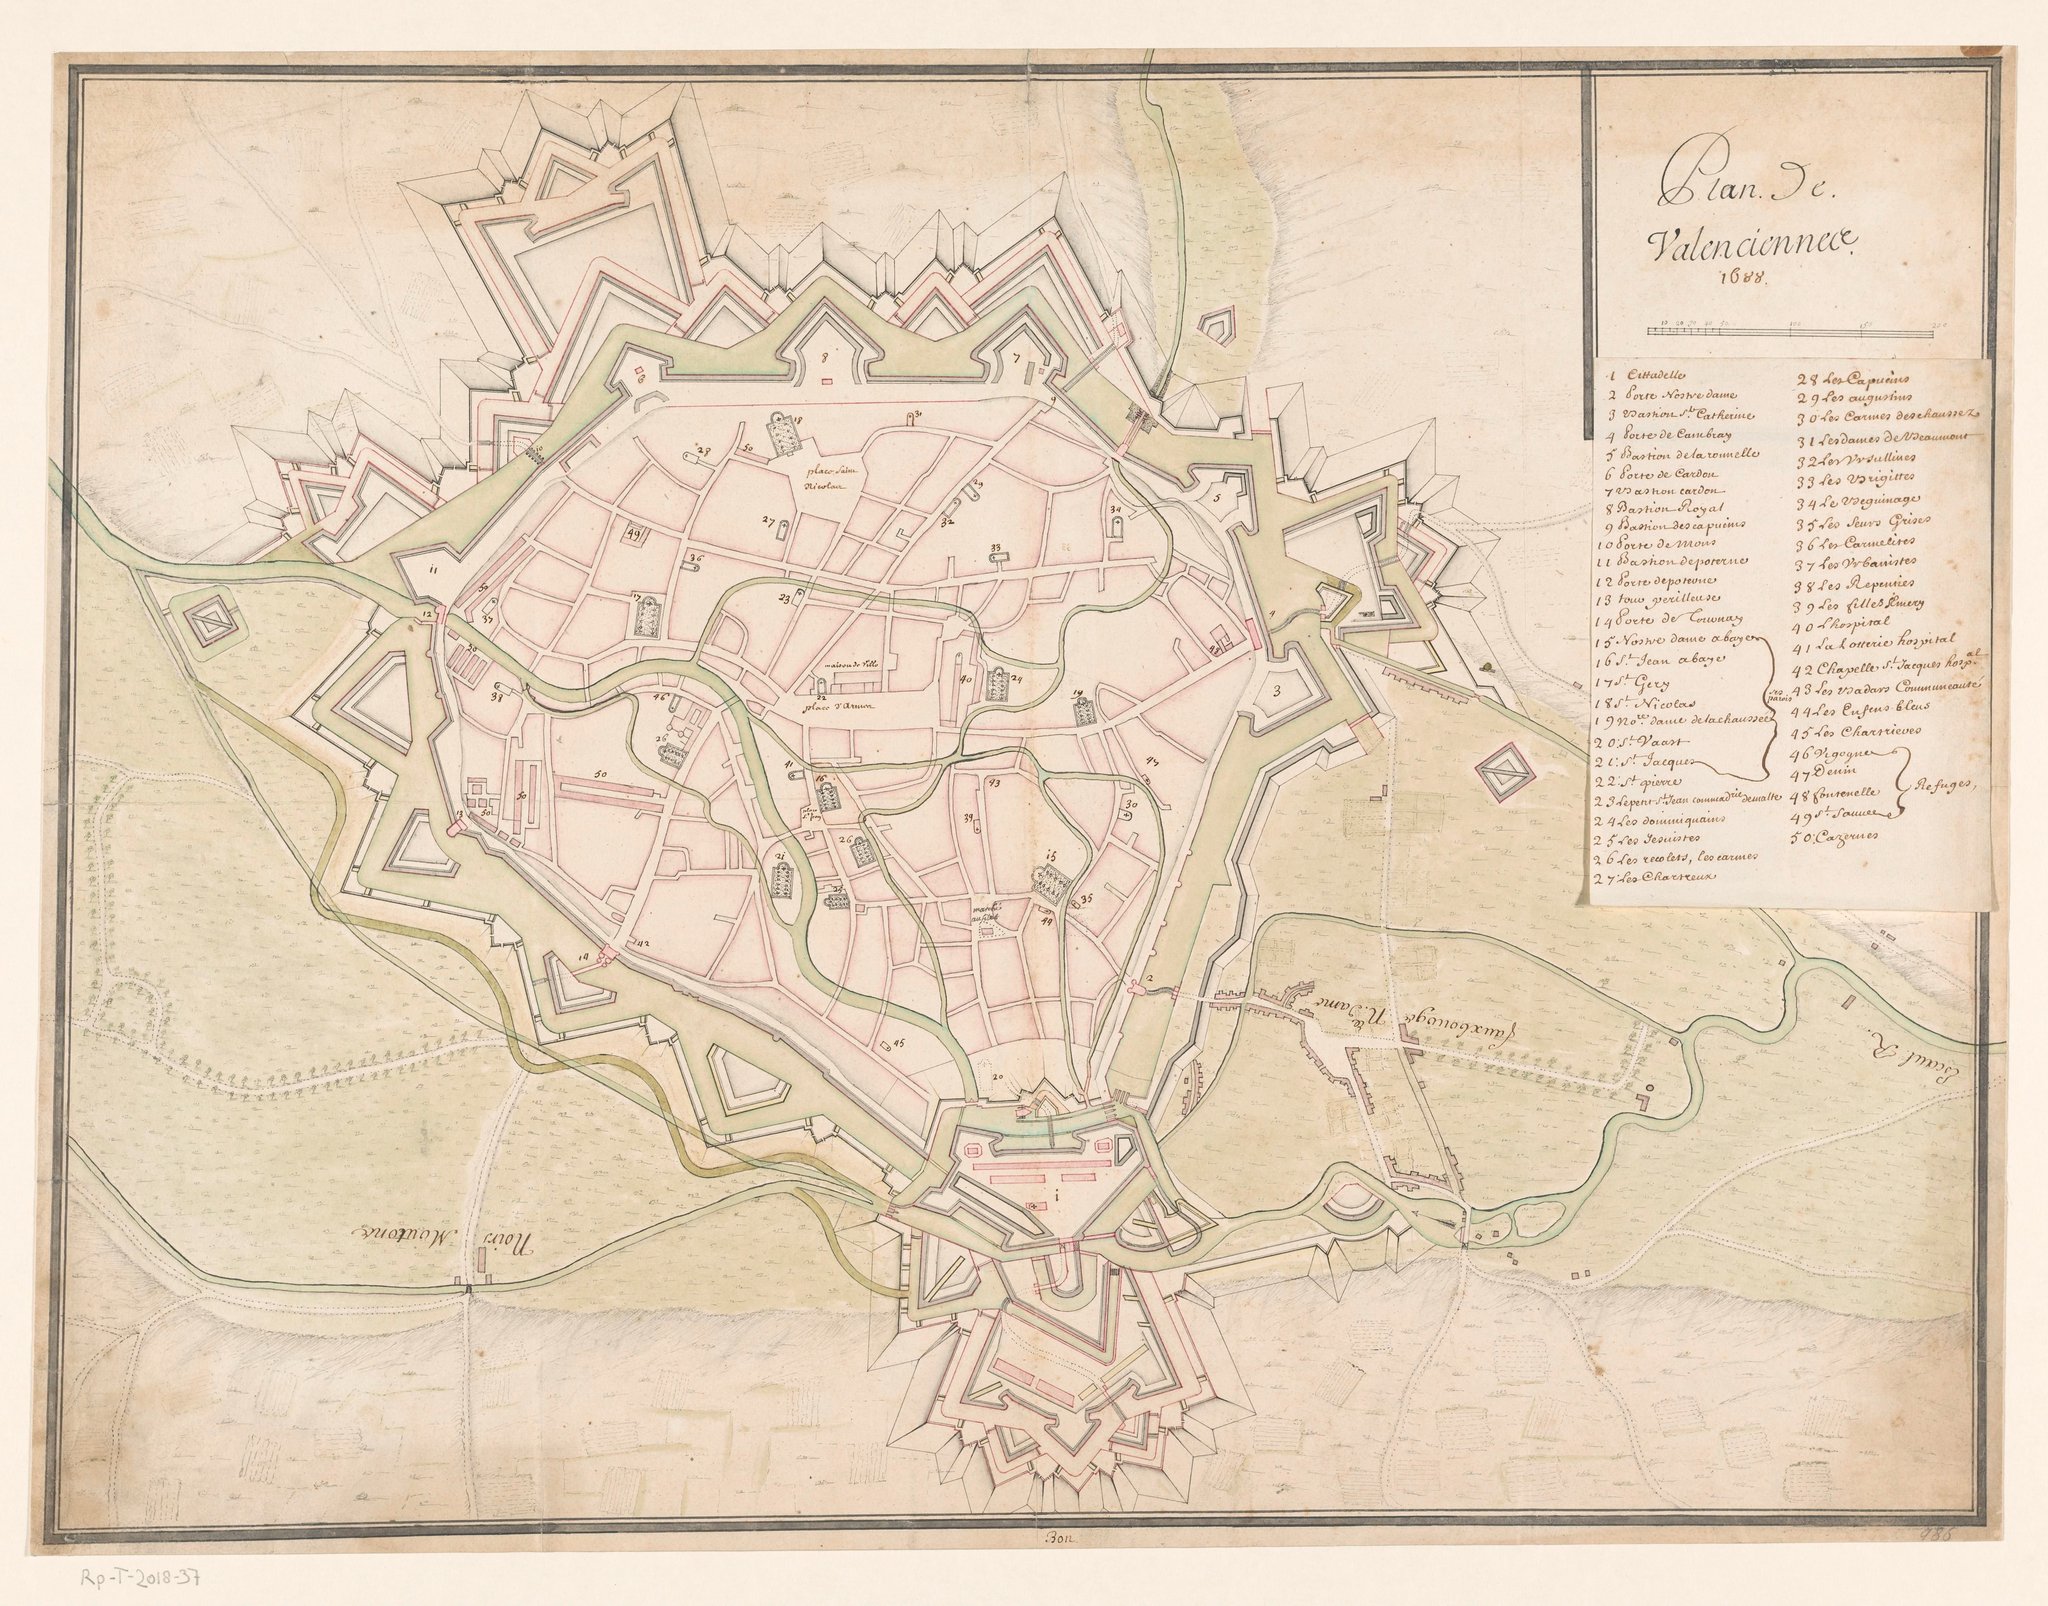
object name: bookplate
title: Rossica/ Russisches Antiquariat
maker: Anonymous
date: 1921-1932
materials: paper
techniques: printing block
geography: germany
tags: flowers, book